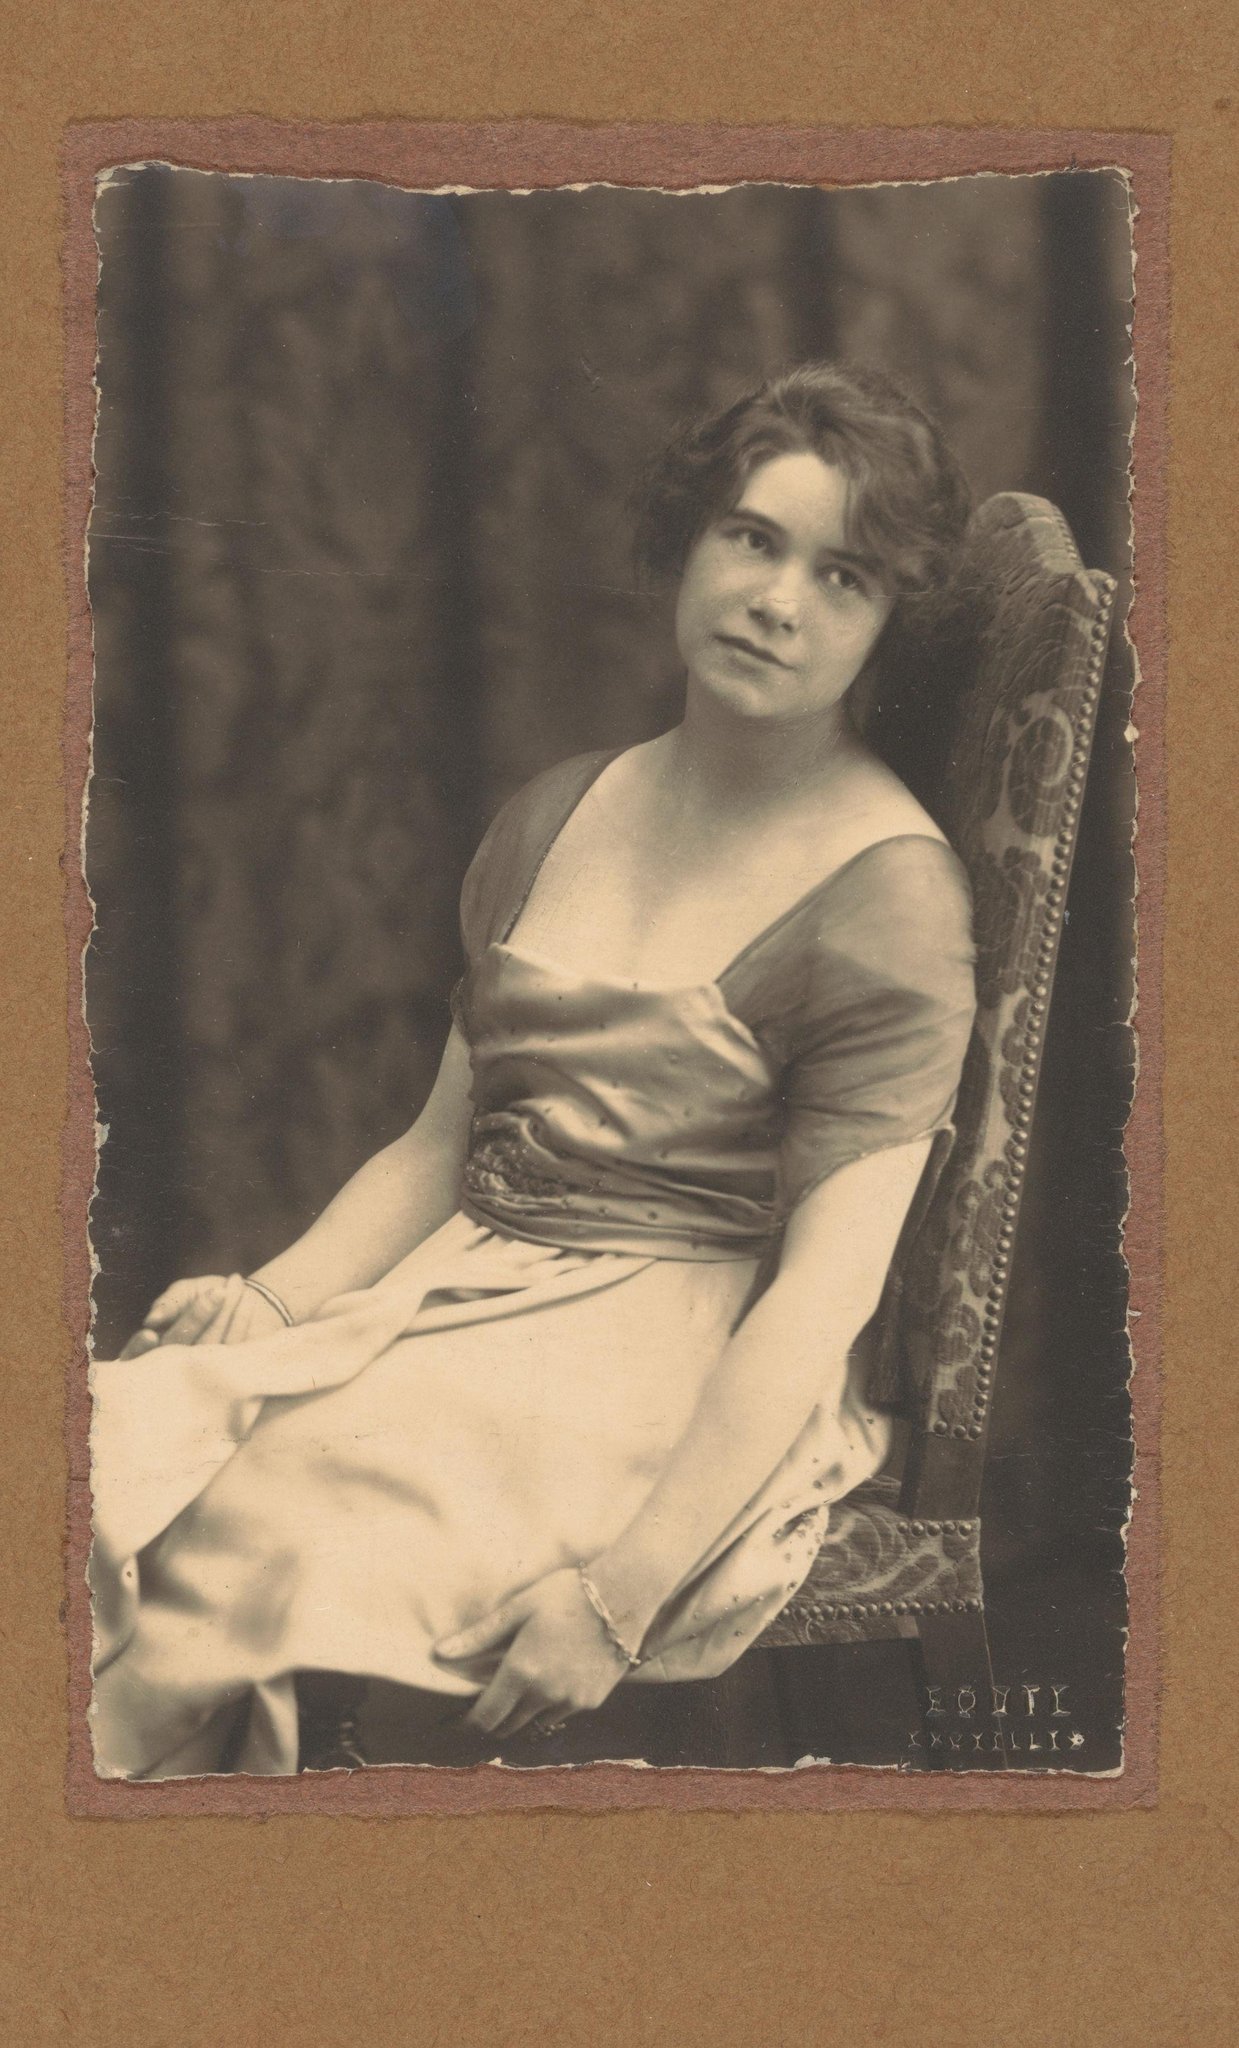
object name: photograph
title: Portret van mezzosopraan Berthe Seroen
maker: Anonymous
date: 1900-1935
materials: photographic support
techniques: gelatin silver print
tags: mechelen, amsterdam, historical persons - bb - woman, female singer